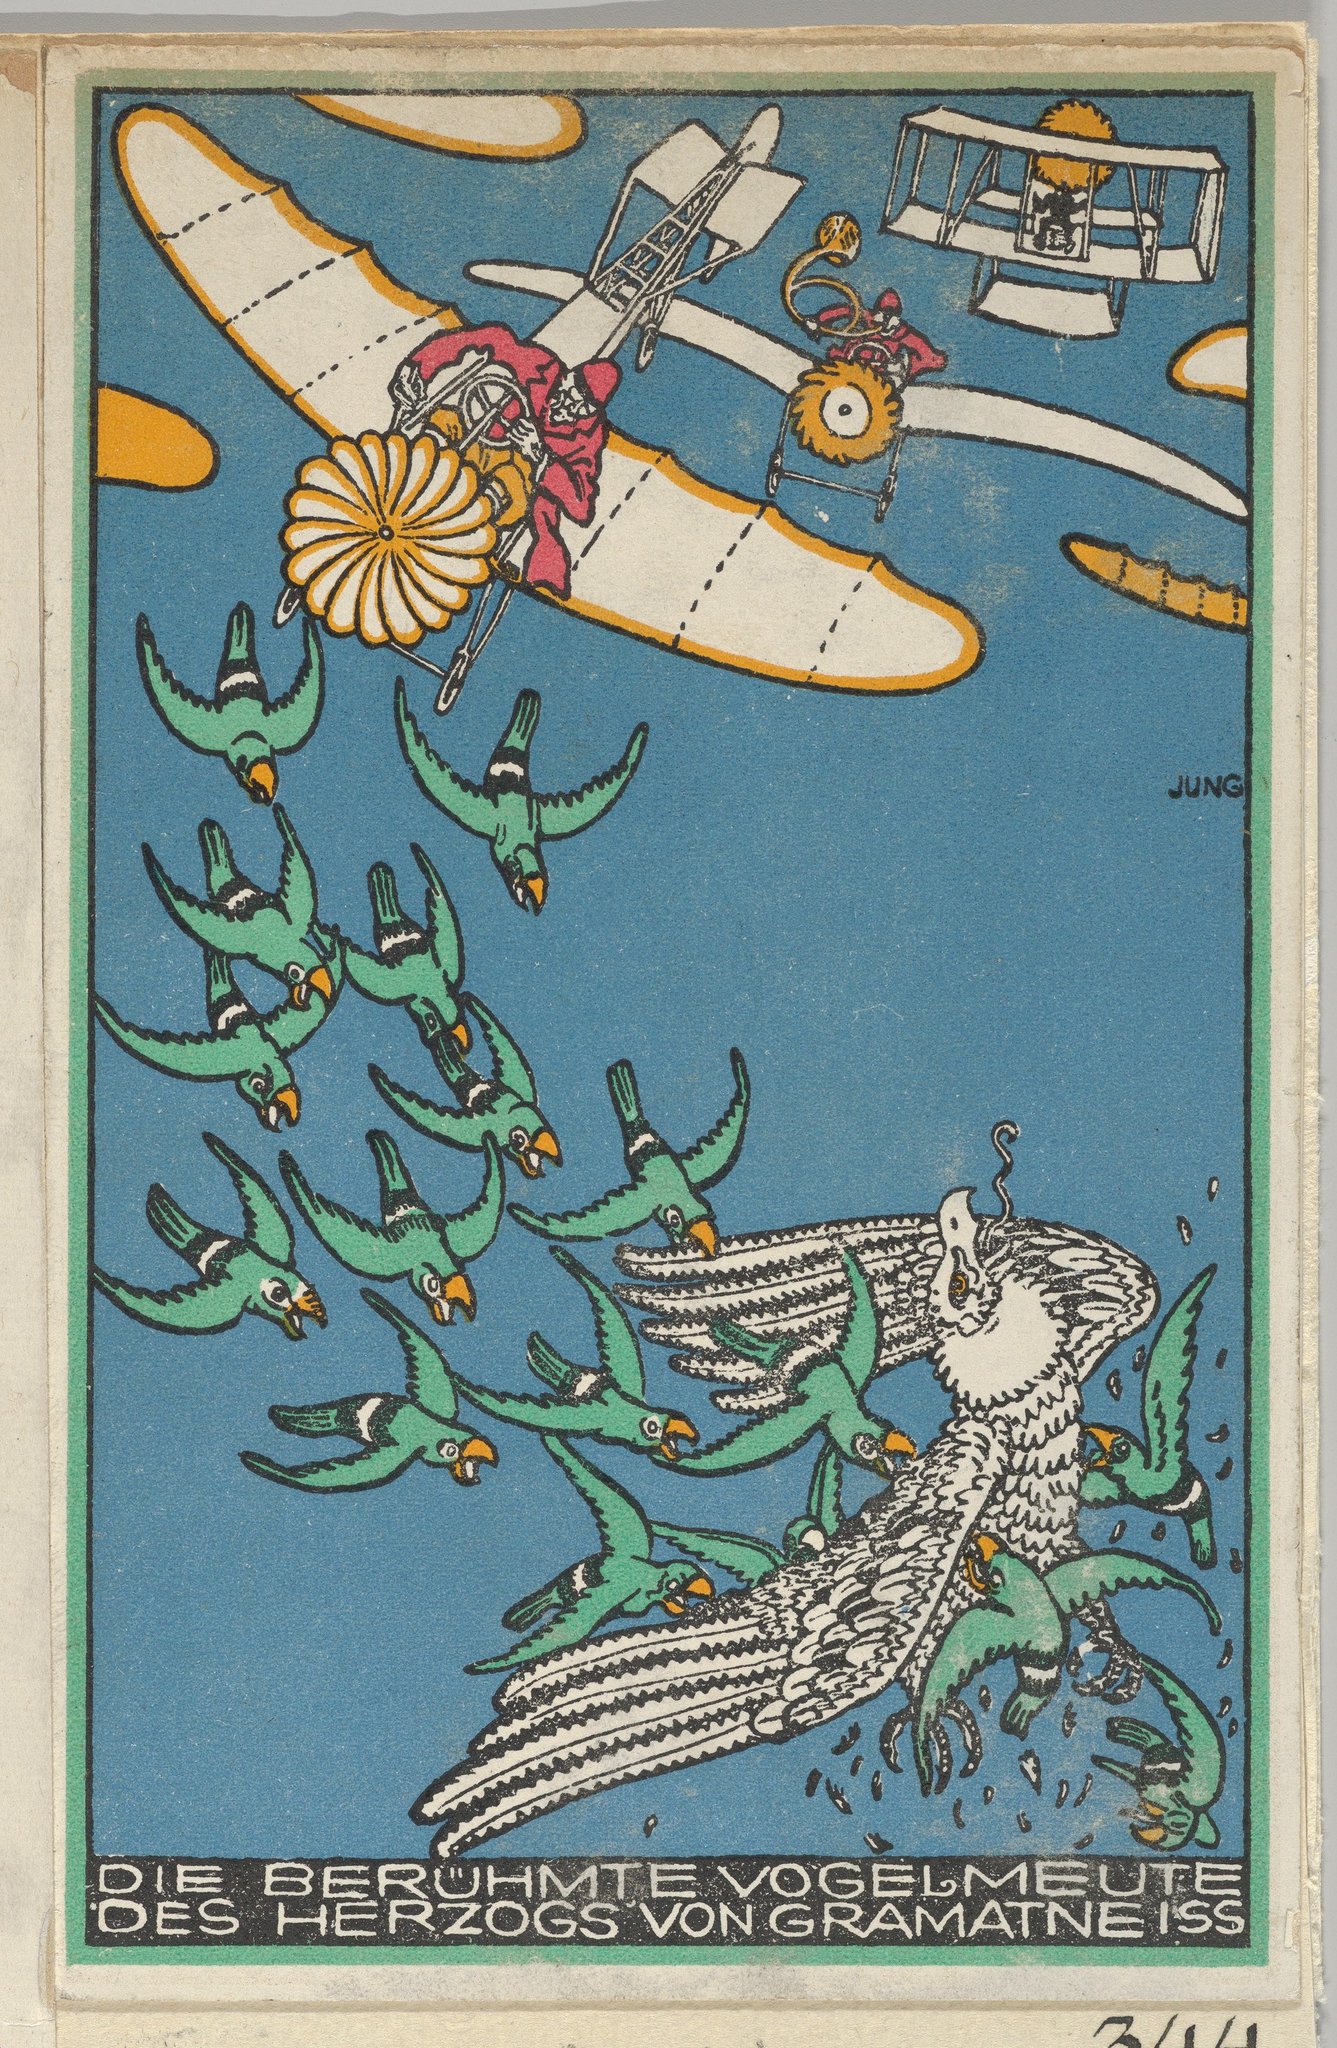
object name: print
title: The Duke of Gramatneiss's Famous Pack of Birds (Die Berühmte Vogelmeute des Herzogs von Gramatneiss)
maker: moriz jung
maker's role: artist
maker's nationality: austrian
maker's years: 1885-1915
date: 1911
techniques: lithograph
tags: birds,planes